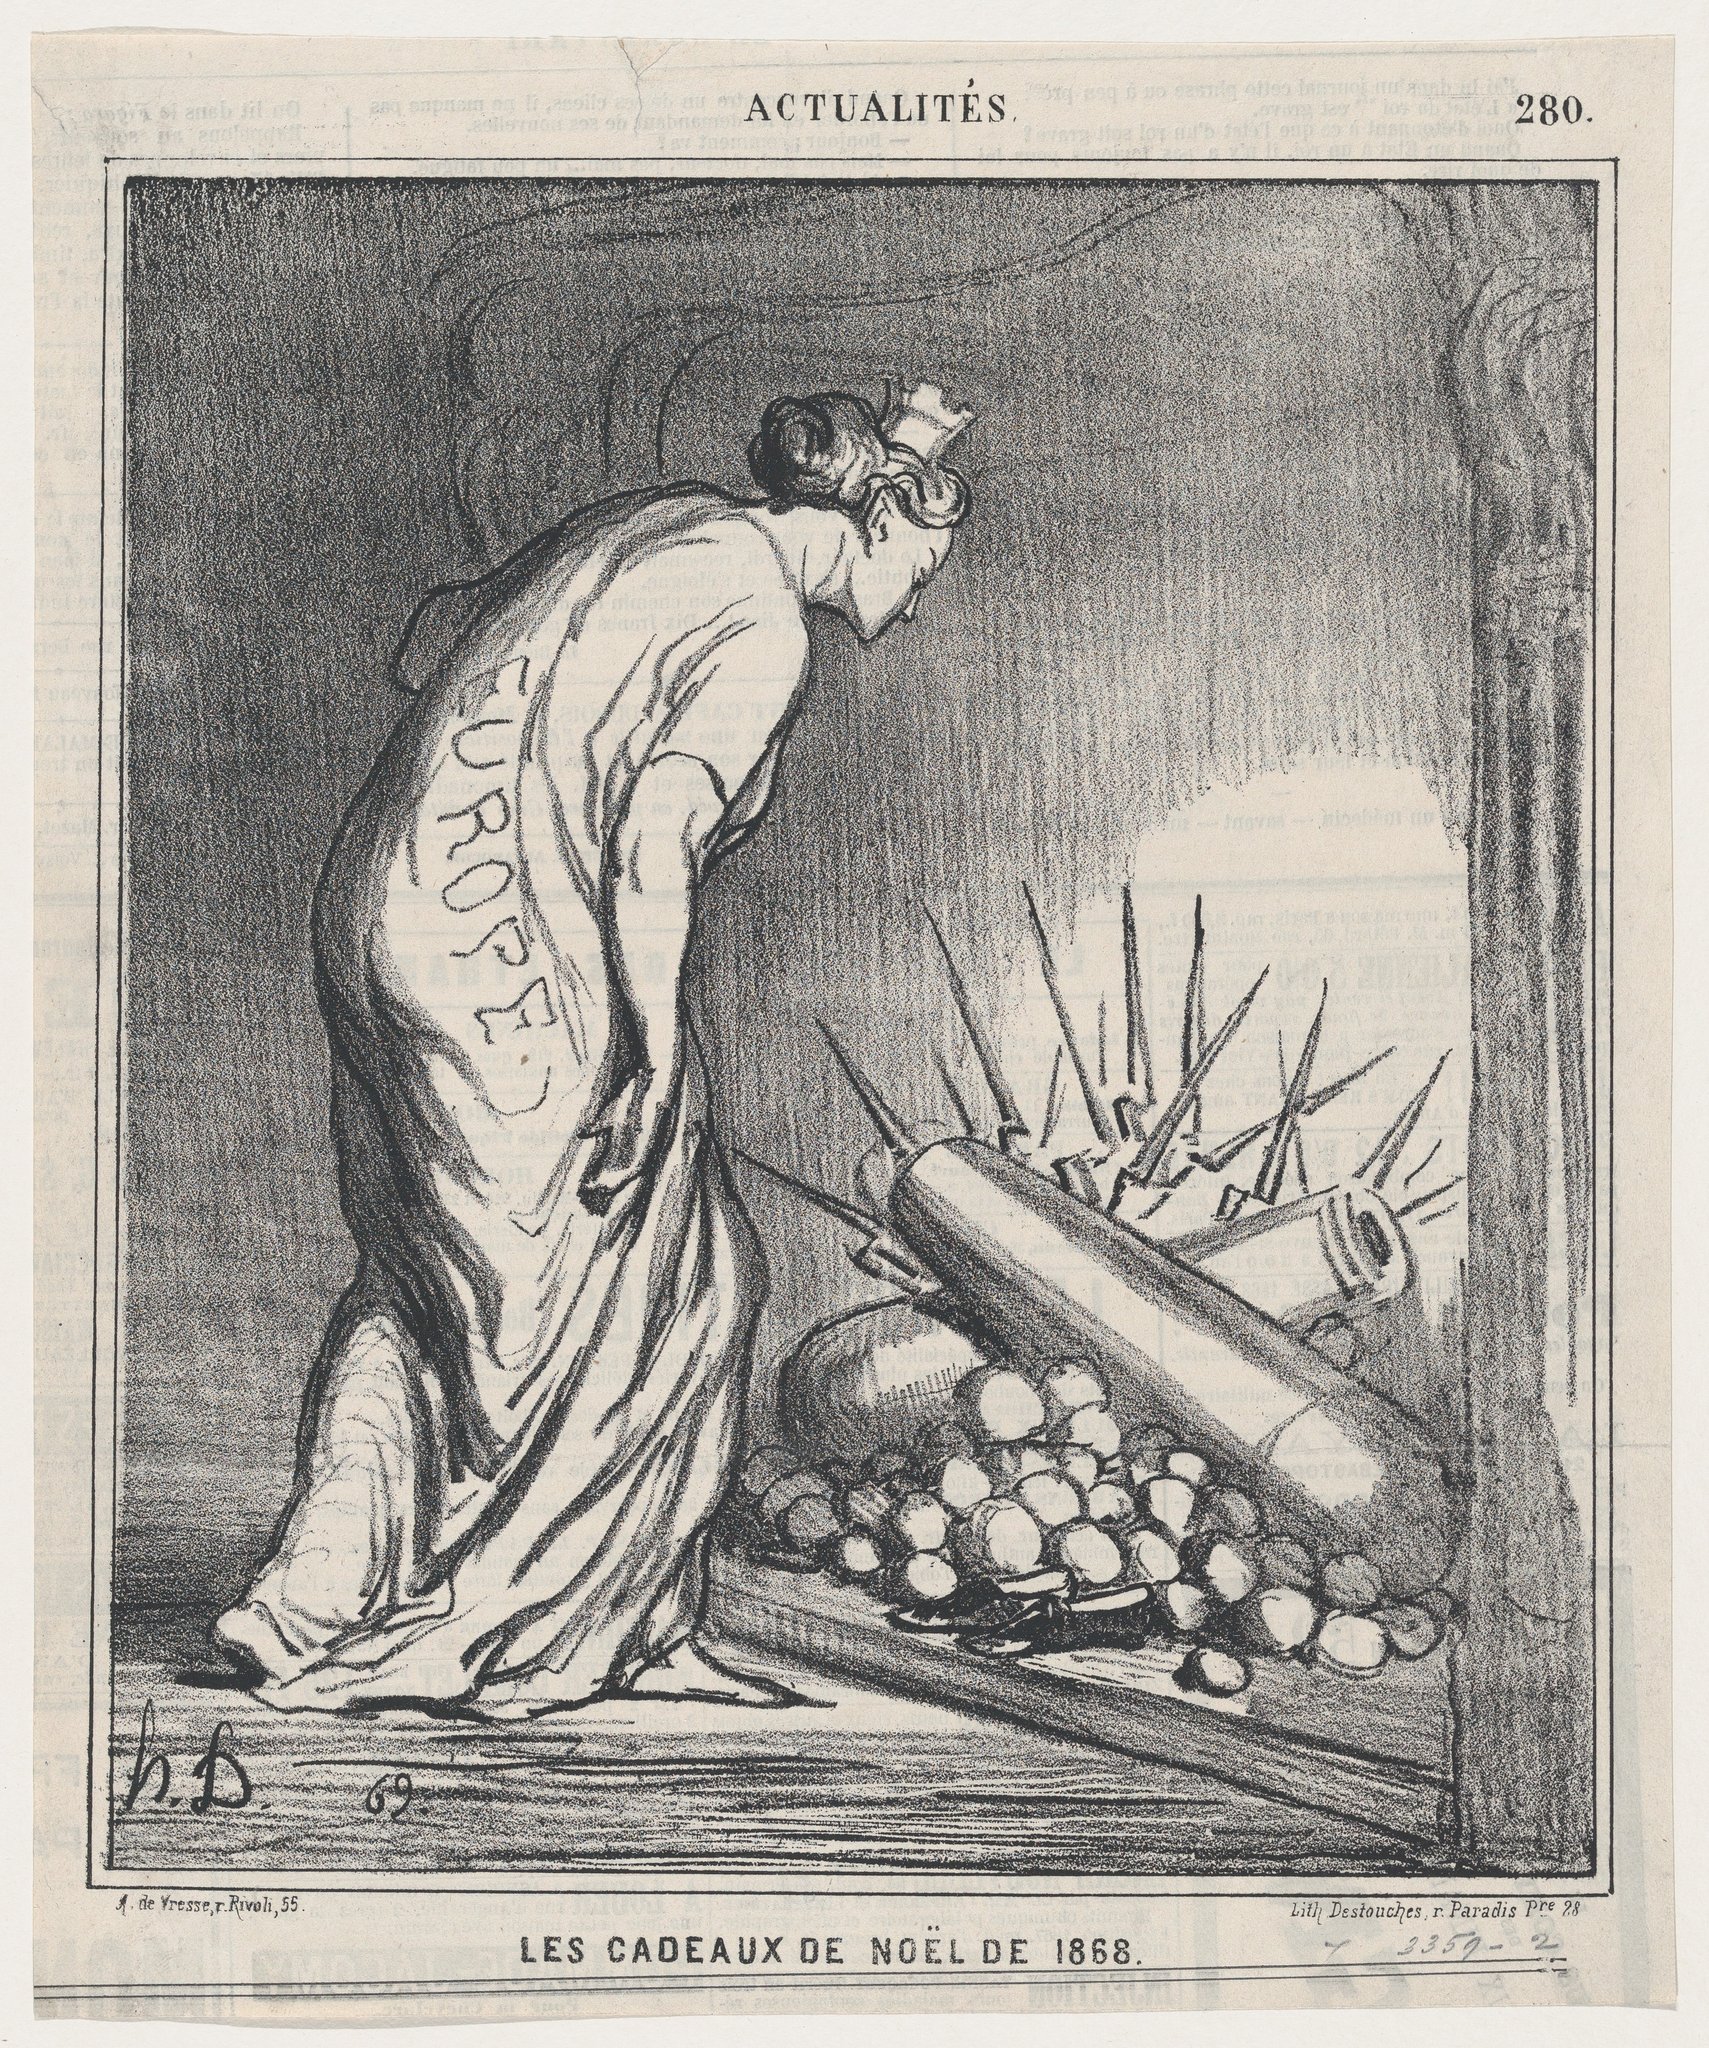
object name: print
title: Christmas presents in 1868, from "News of the day"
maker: honoré daumier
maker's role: artist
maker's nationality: french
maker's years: 1808-1879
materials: paper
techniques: lithograph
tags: women,christmas